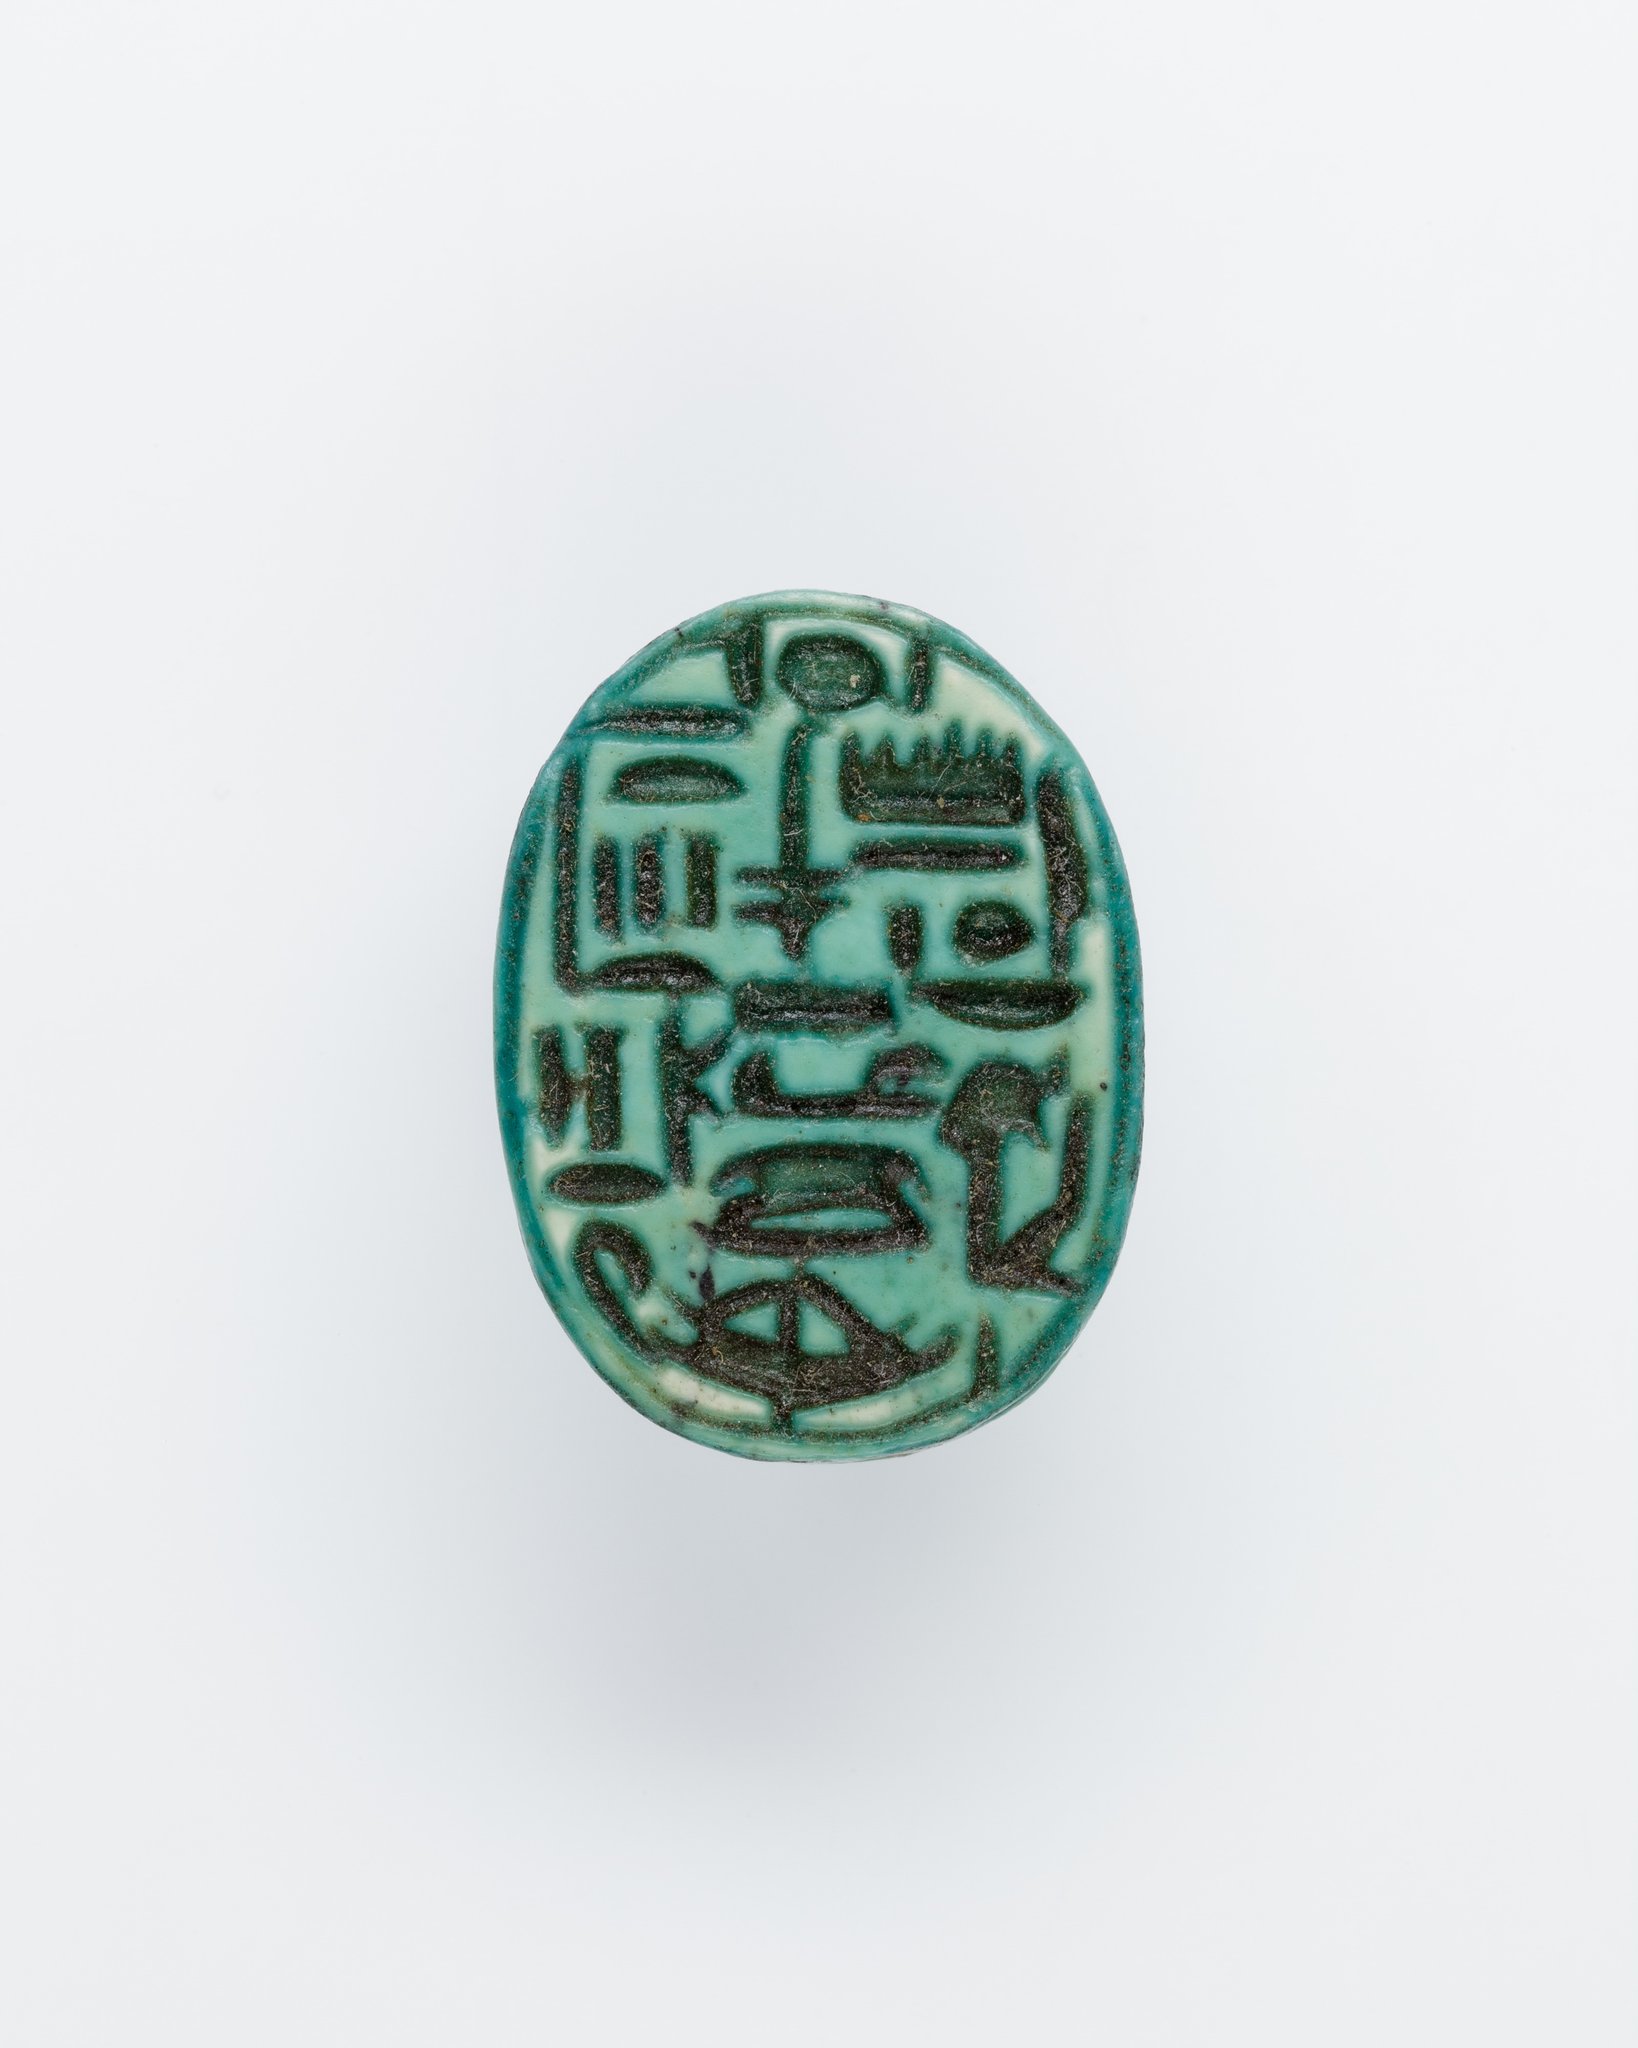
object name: scarab, amun re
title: Scarab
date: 1295-1070 BCE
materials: stone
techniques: glazing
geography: egypt